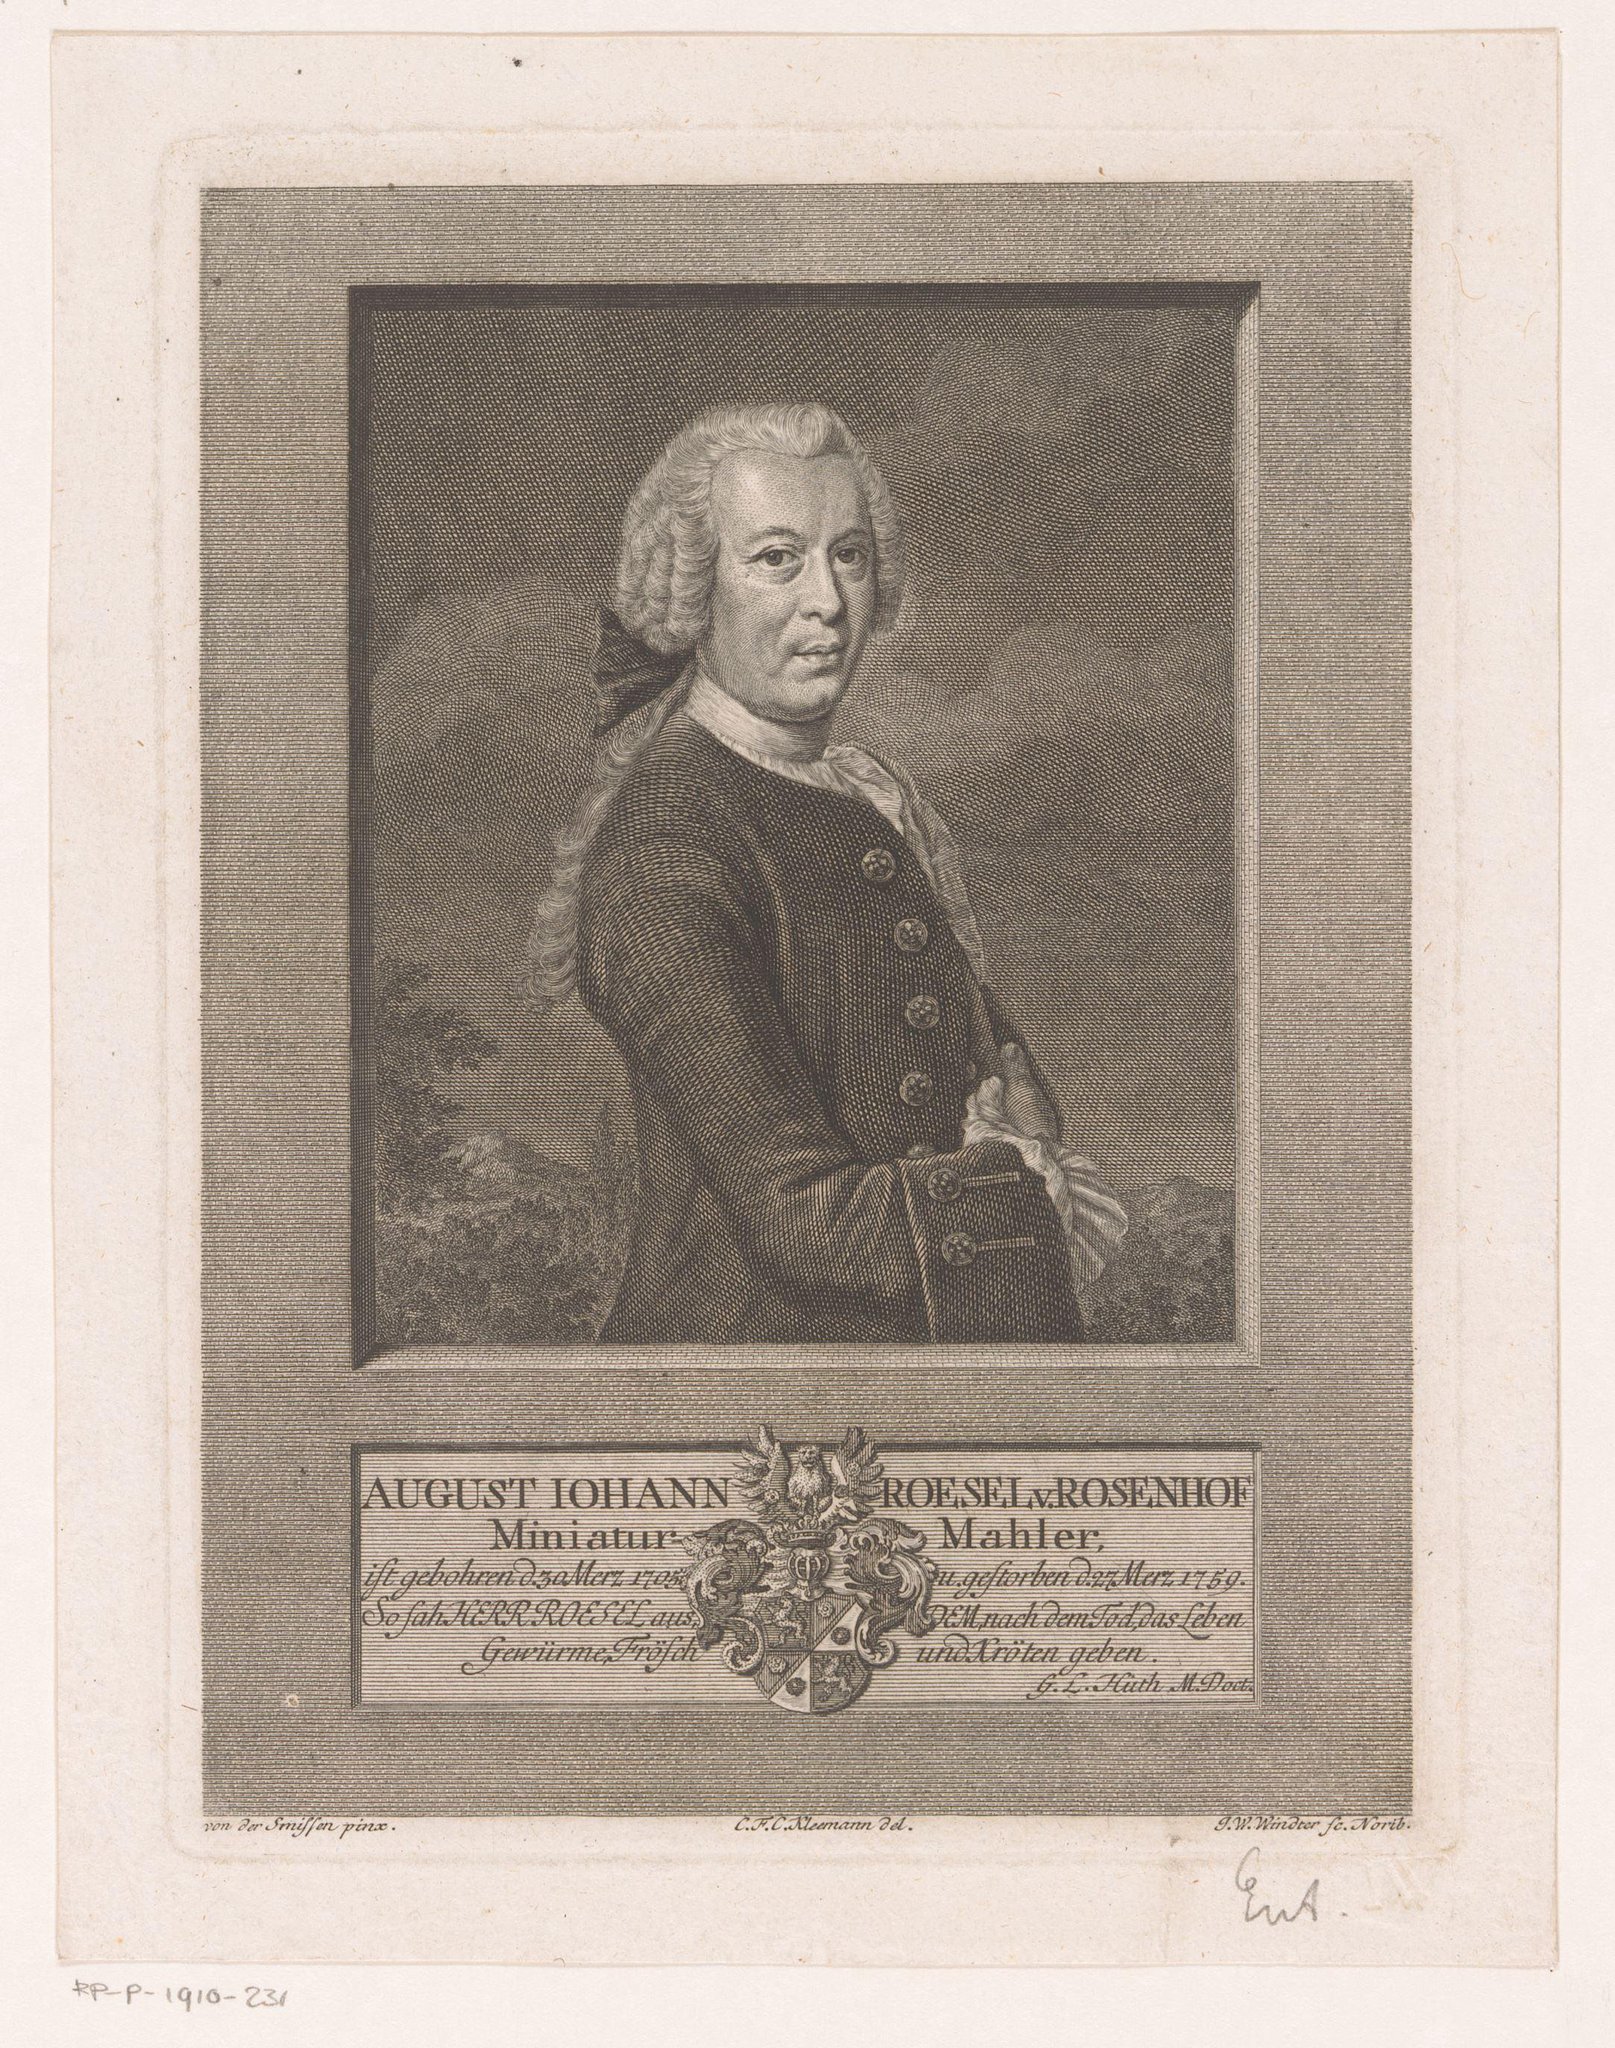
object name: print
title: Portret van August Johann Rösel von Rosenhof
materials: paper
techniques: engraving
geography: nuremberg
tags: painter, print maker, historical persons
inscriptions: collector's mark: Lugt 2228